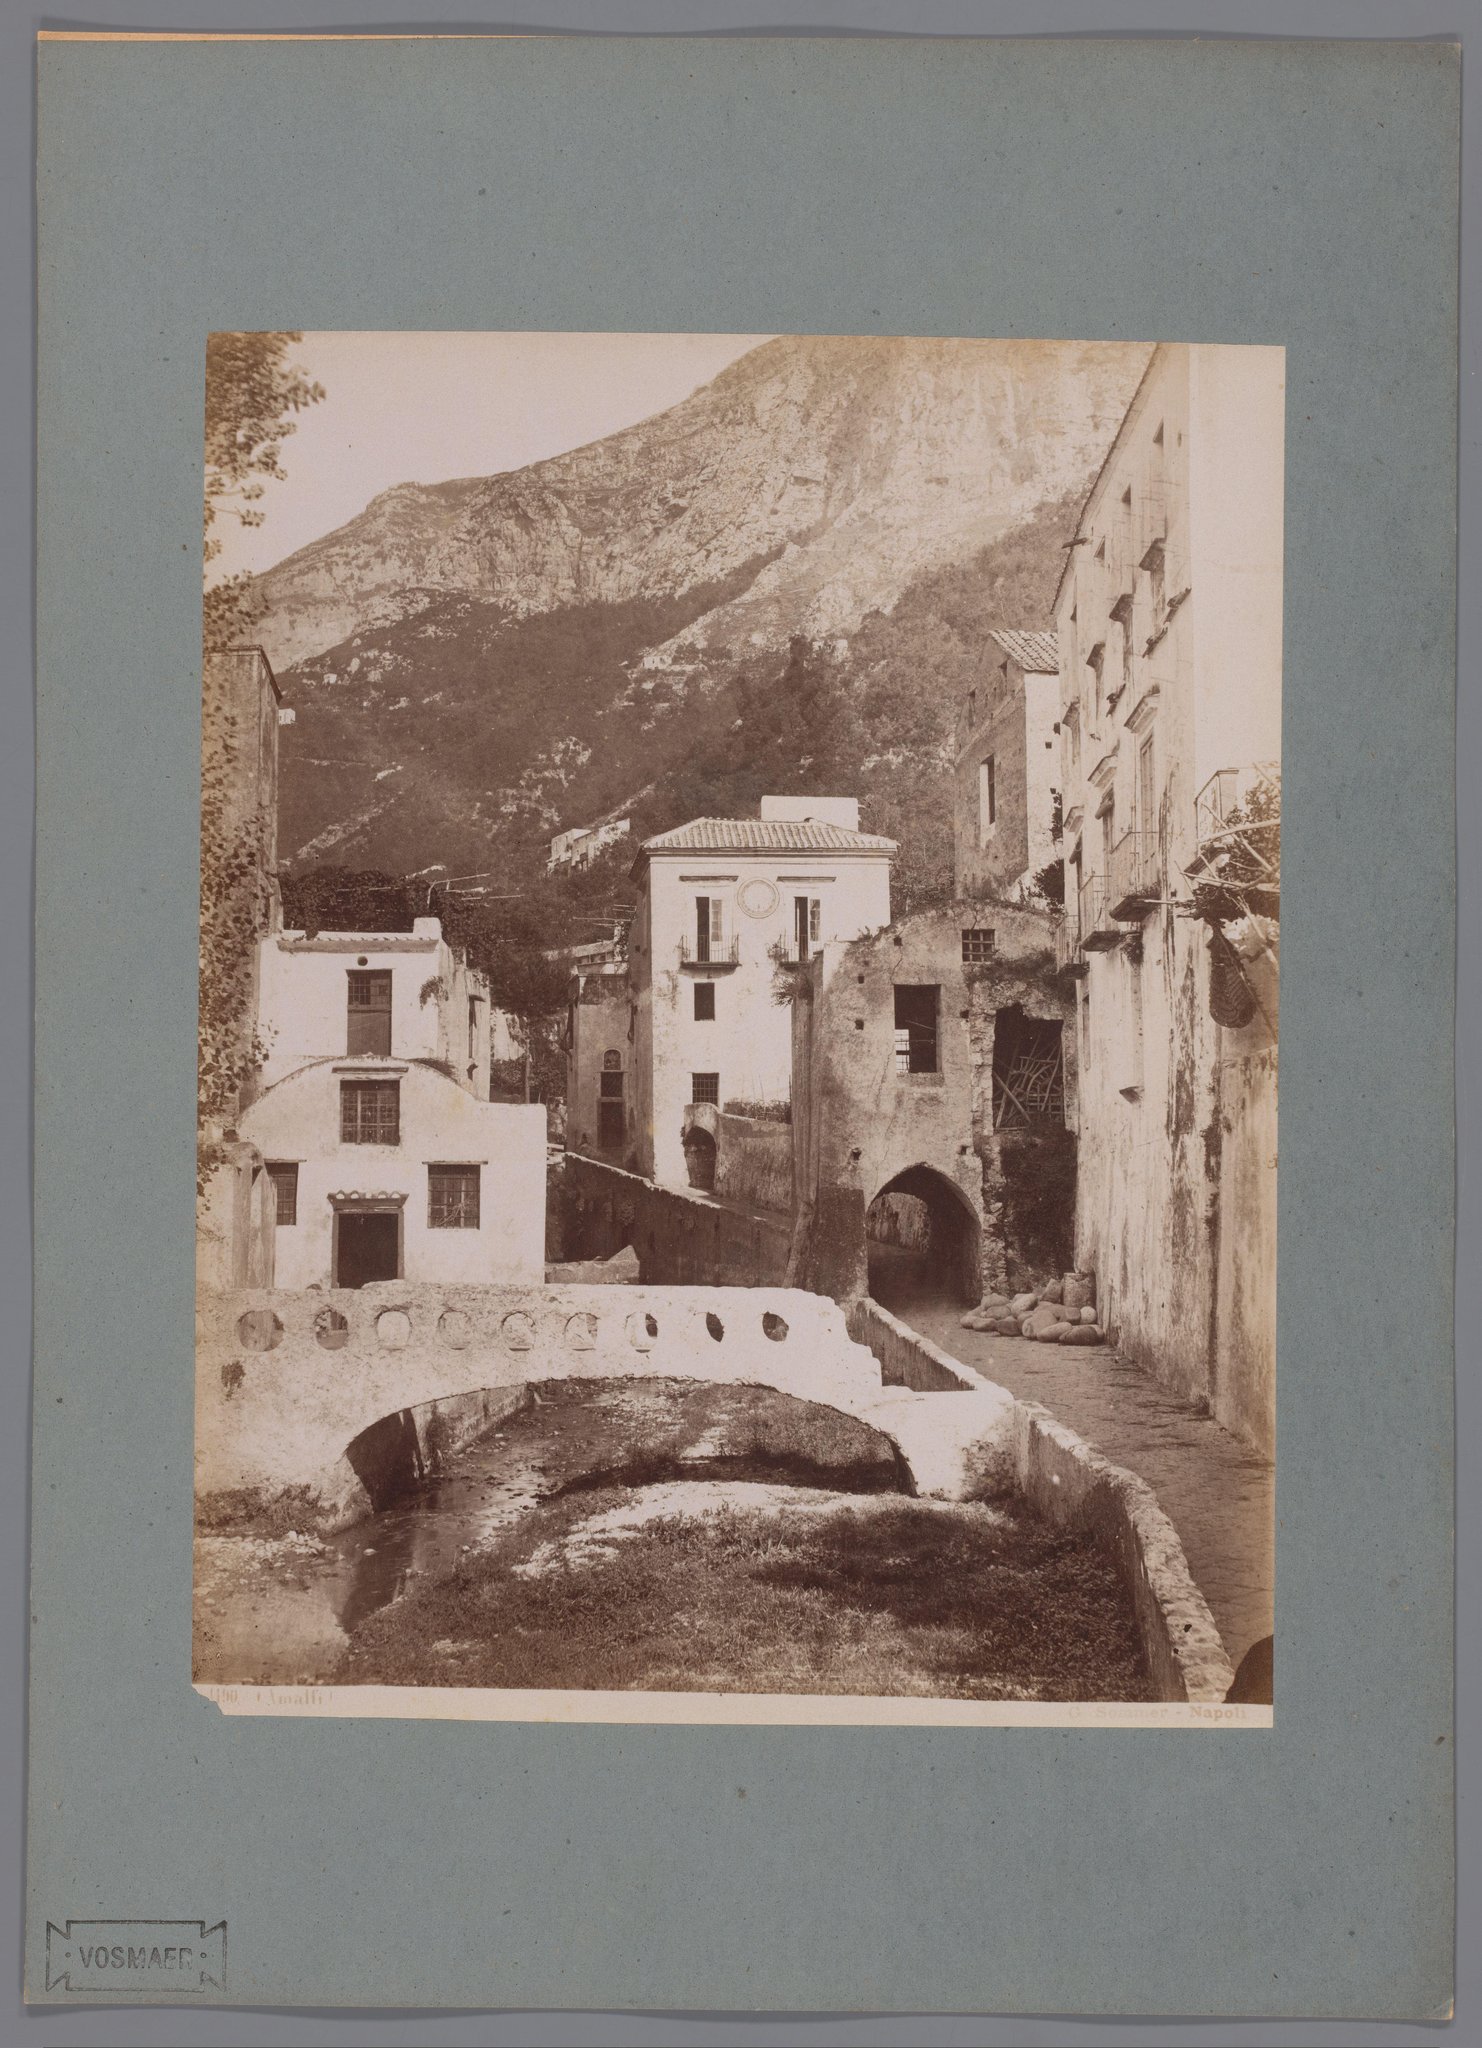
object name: photograph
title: Amalfi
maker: giorgio sommer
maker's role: fotograaf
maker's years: 1834-1914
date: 1870-1890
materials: cardboard, paper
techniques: albumen print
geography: amalfi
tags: city-view in general; 'veduta', amalfi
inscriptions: collector's mark: ‘VOSMAER’, number: ‘1490’, inscription: ‘doos 10’